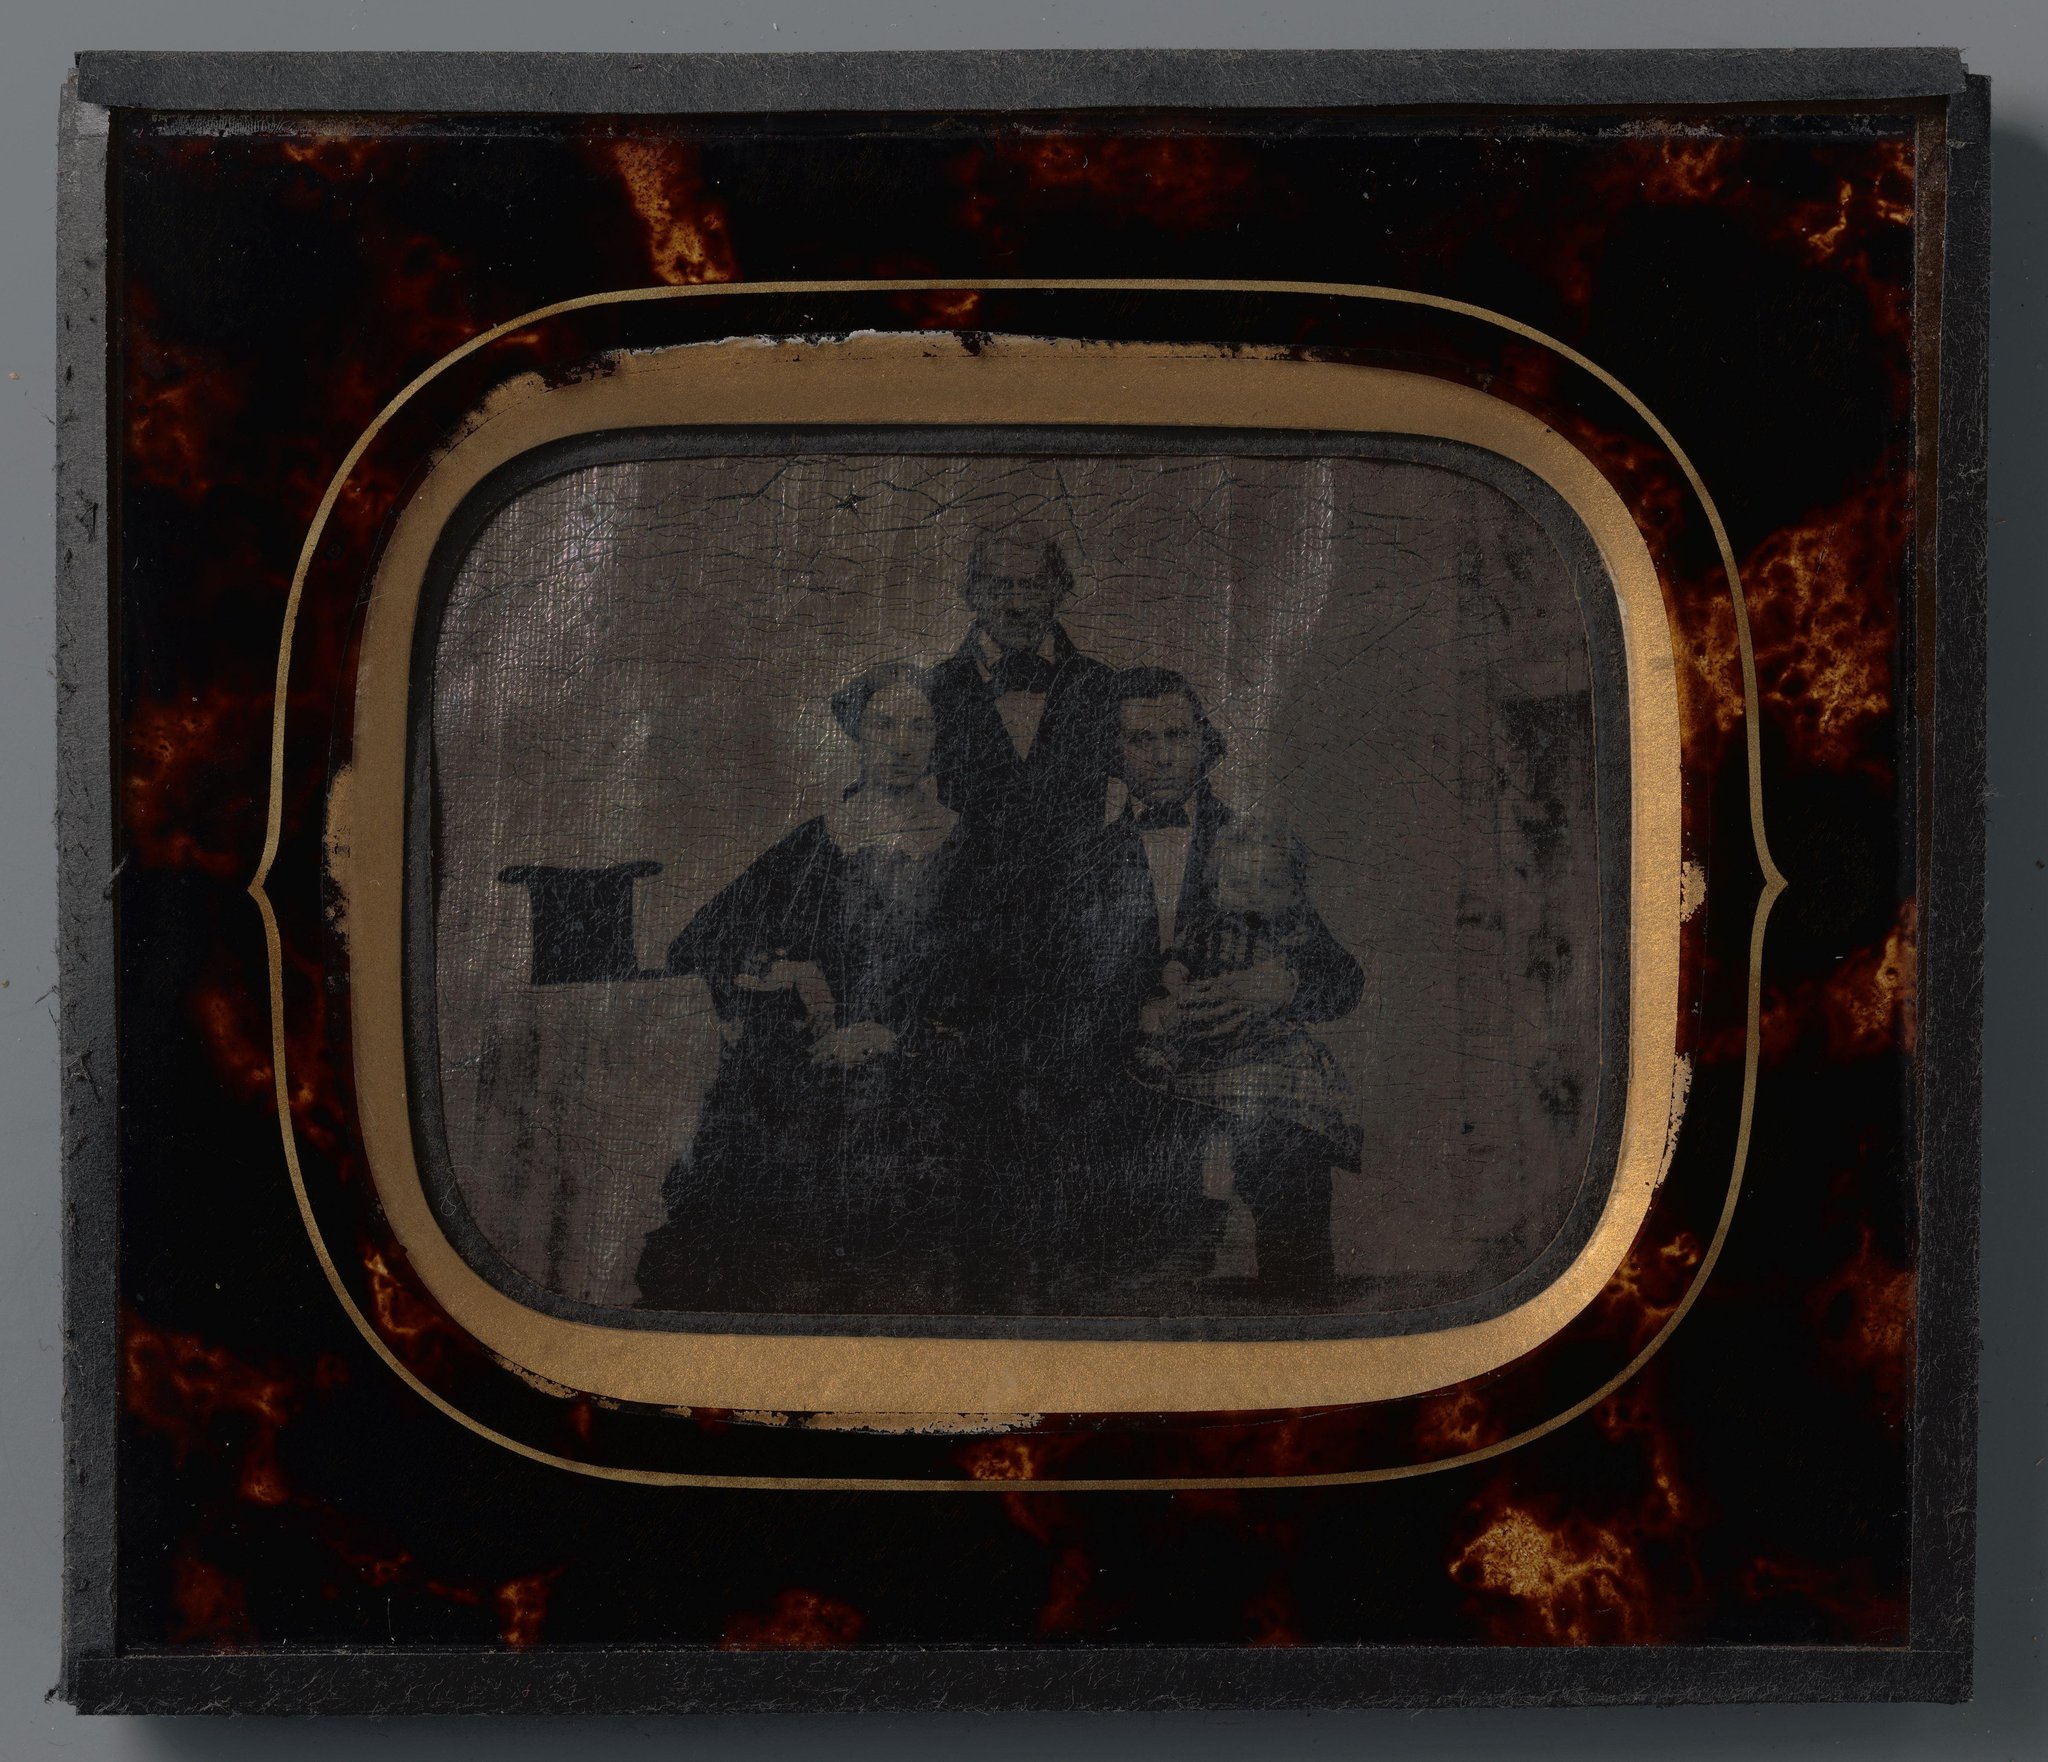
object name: photograph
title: Portret van een gezin met grootvader en kind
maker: Anonymous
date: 1853-1863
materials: celluloid, glass, linen, paper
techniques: pannotype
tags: adult man (+ two persons), adult woman, family life, infant, baby ~ the ages of man, anonymous historical persons portrayed in a group, in a group-portrait